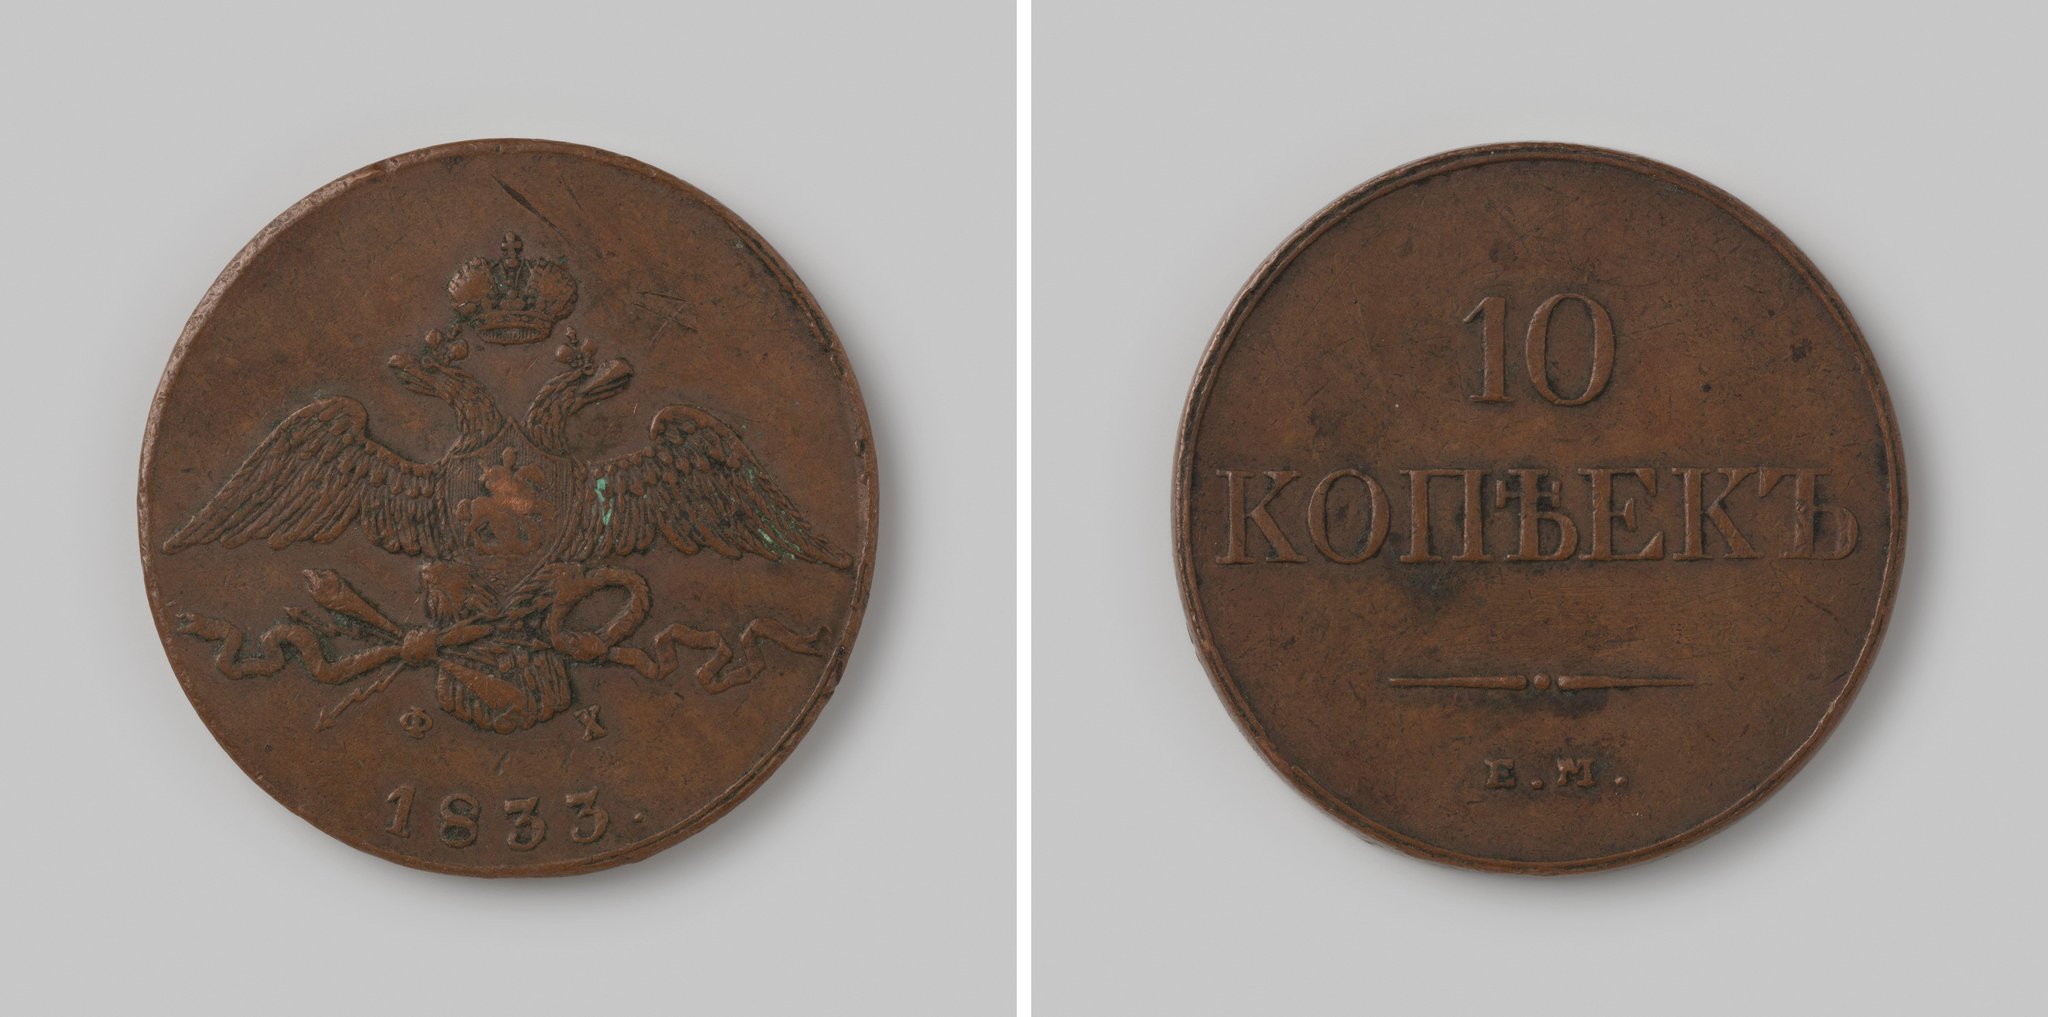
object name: coin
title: 10 kopeken uit Rusland van tsaar Nikolai I, 1833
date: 1833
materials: copper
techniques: striking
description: Koperen munt. Voorzijde: dubbelkoppige gekroonde adelaar met gespreide vleugels en met op zijn bosrt een wapenschild en onder op zijn staart verschillende attributen. Daaronder jaartal. Boven de adelaar een kroon. Keerzijde: in twee regels waarde-aanduiding, waaronder in het Cyrillisch de letters E en M [=Ekaterinenburg]. Gladde rand.